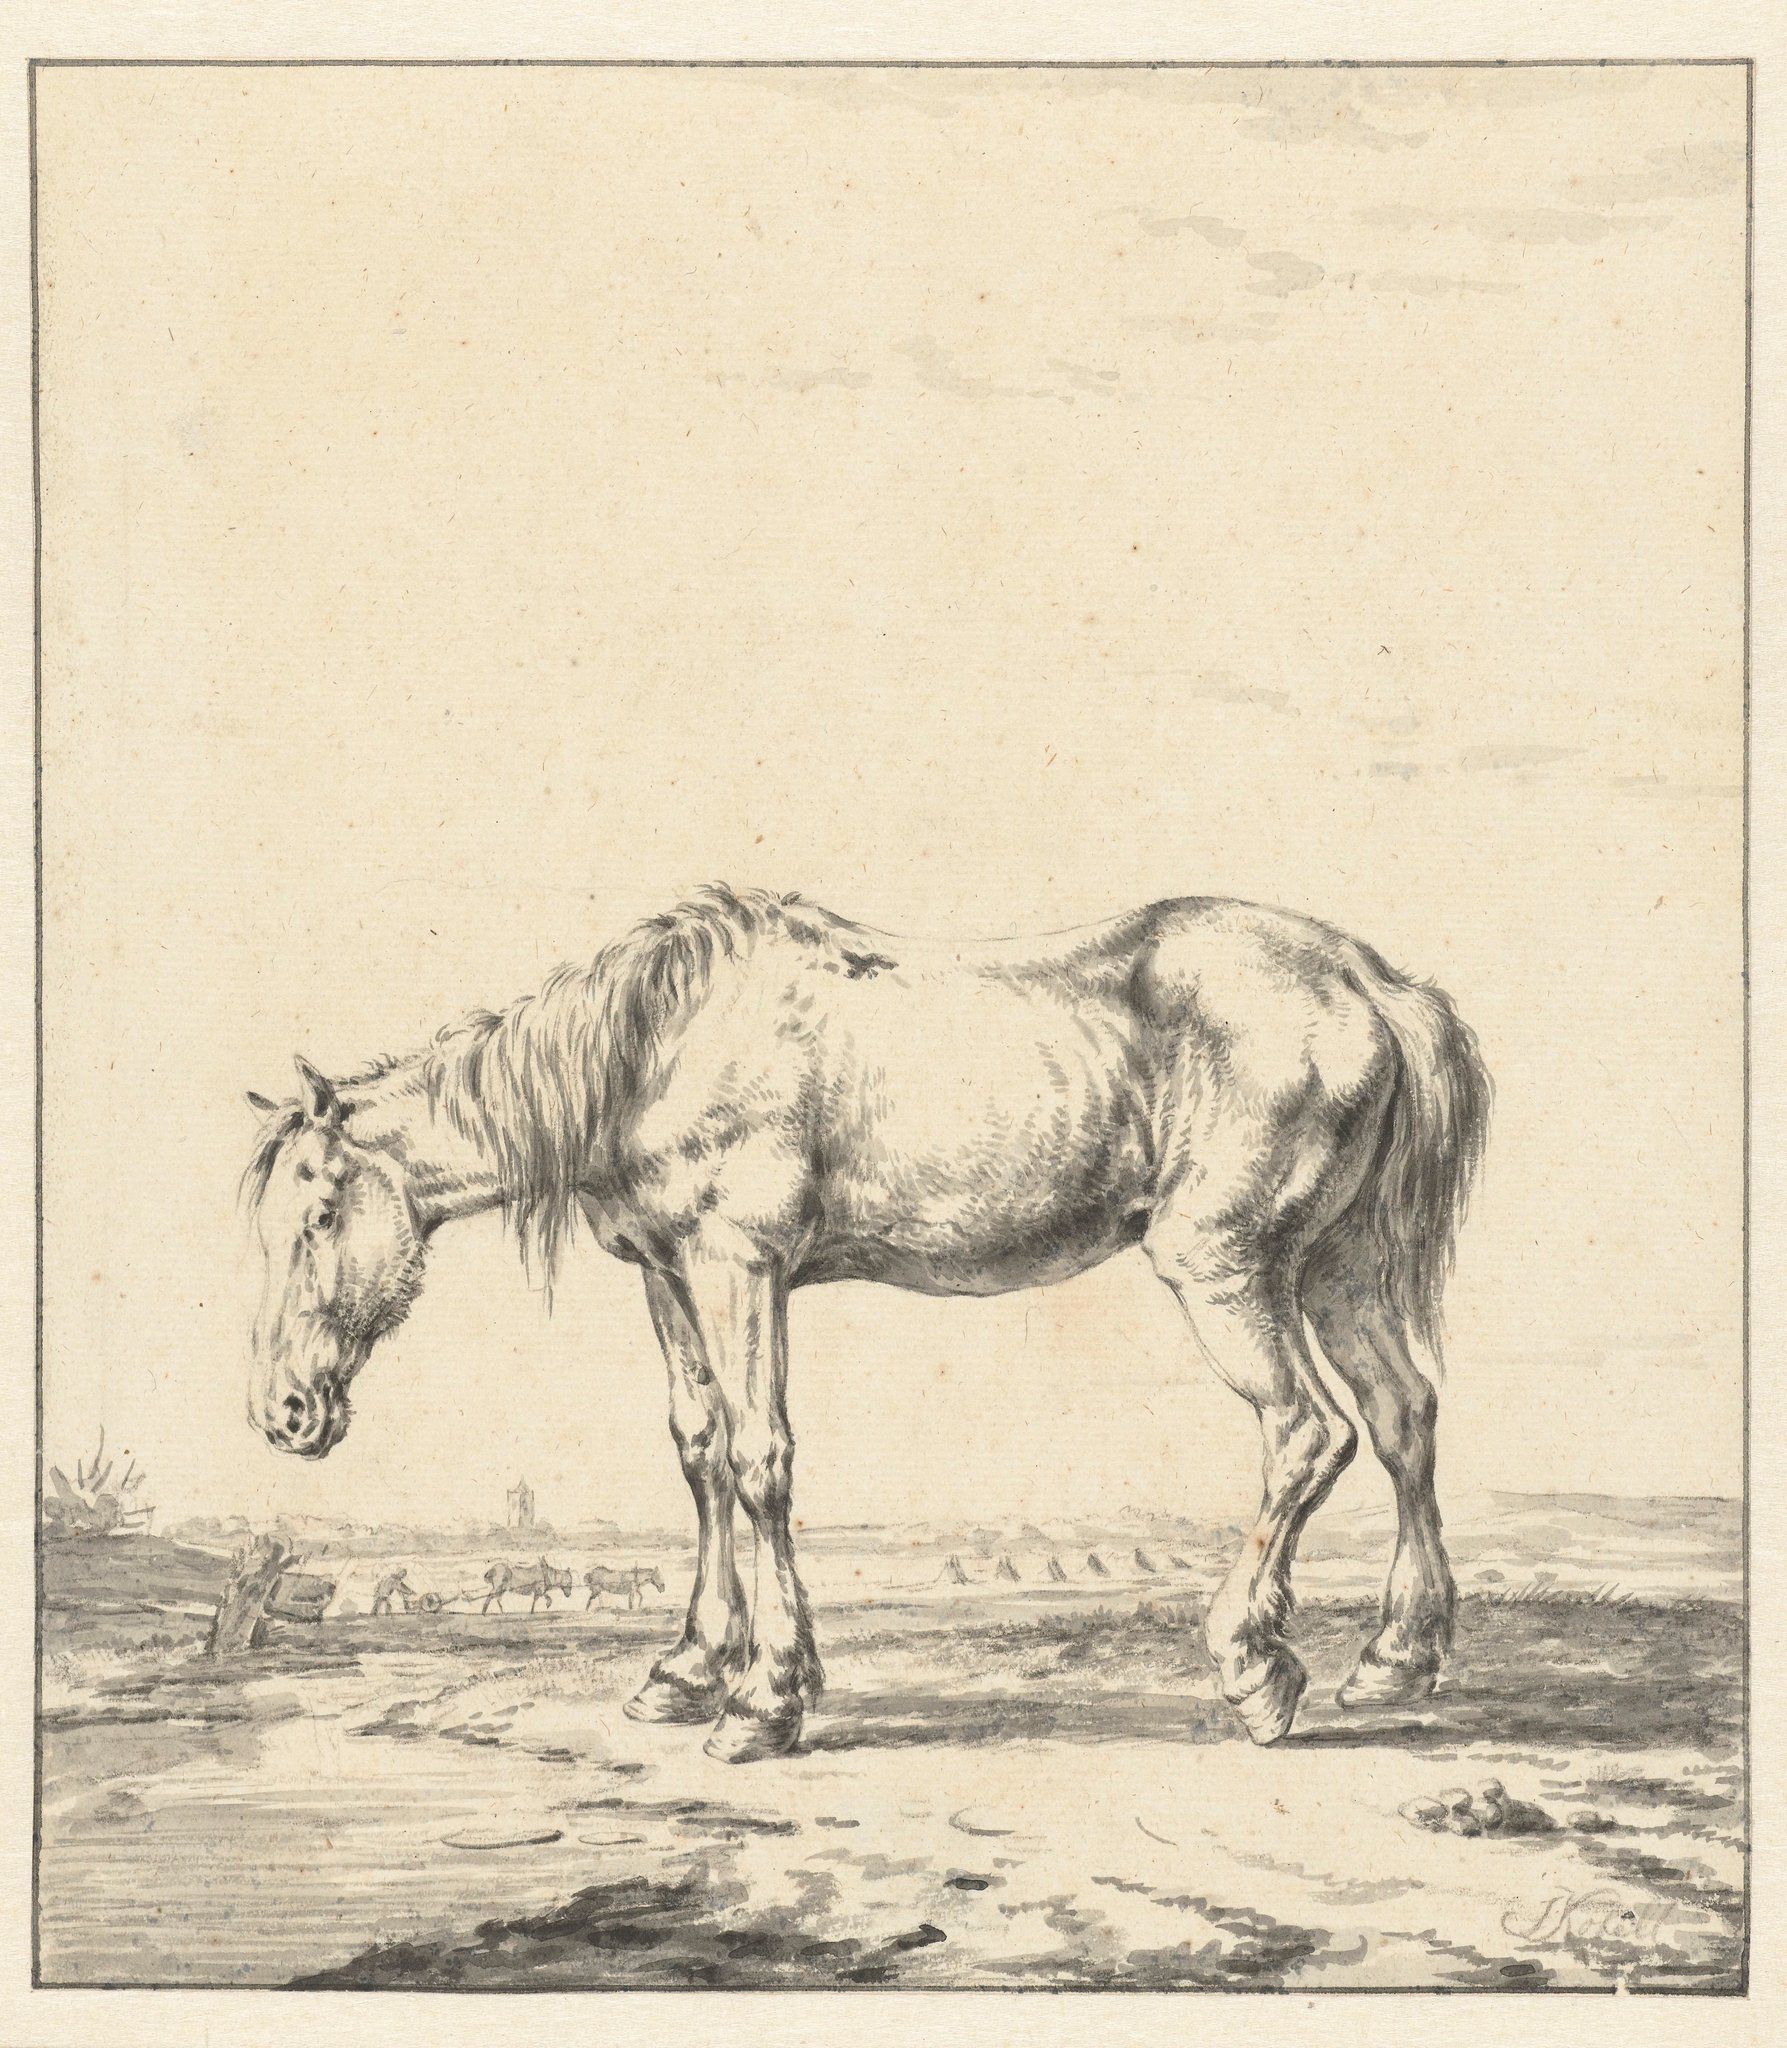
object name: drawing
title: Oud paard bij een water staande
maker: jan kobell (ii)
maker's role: draughtsman, painter, print maker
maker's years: 1778-1814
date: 1788-1814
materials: chalk, paper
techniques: brush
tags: horse